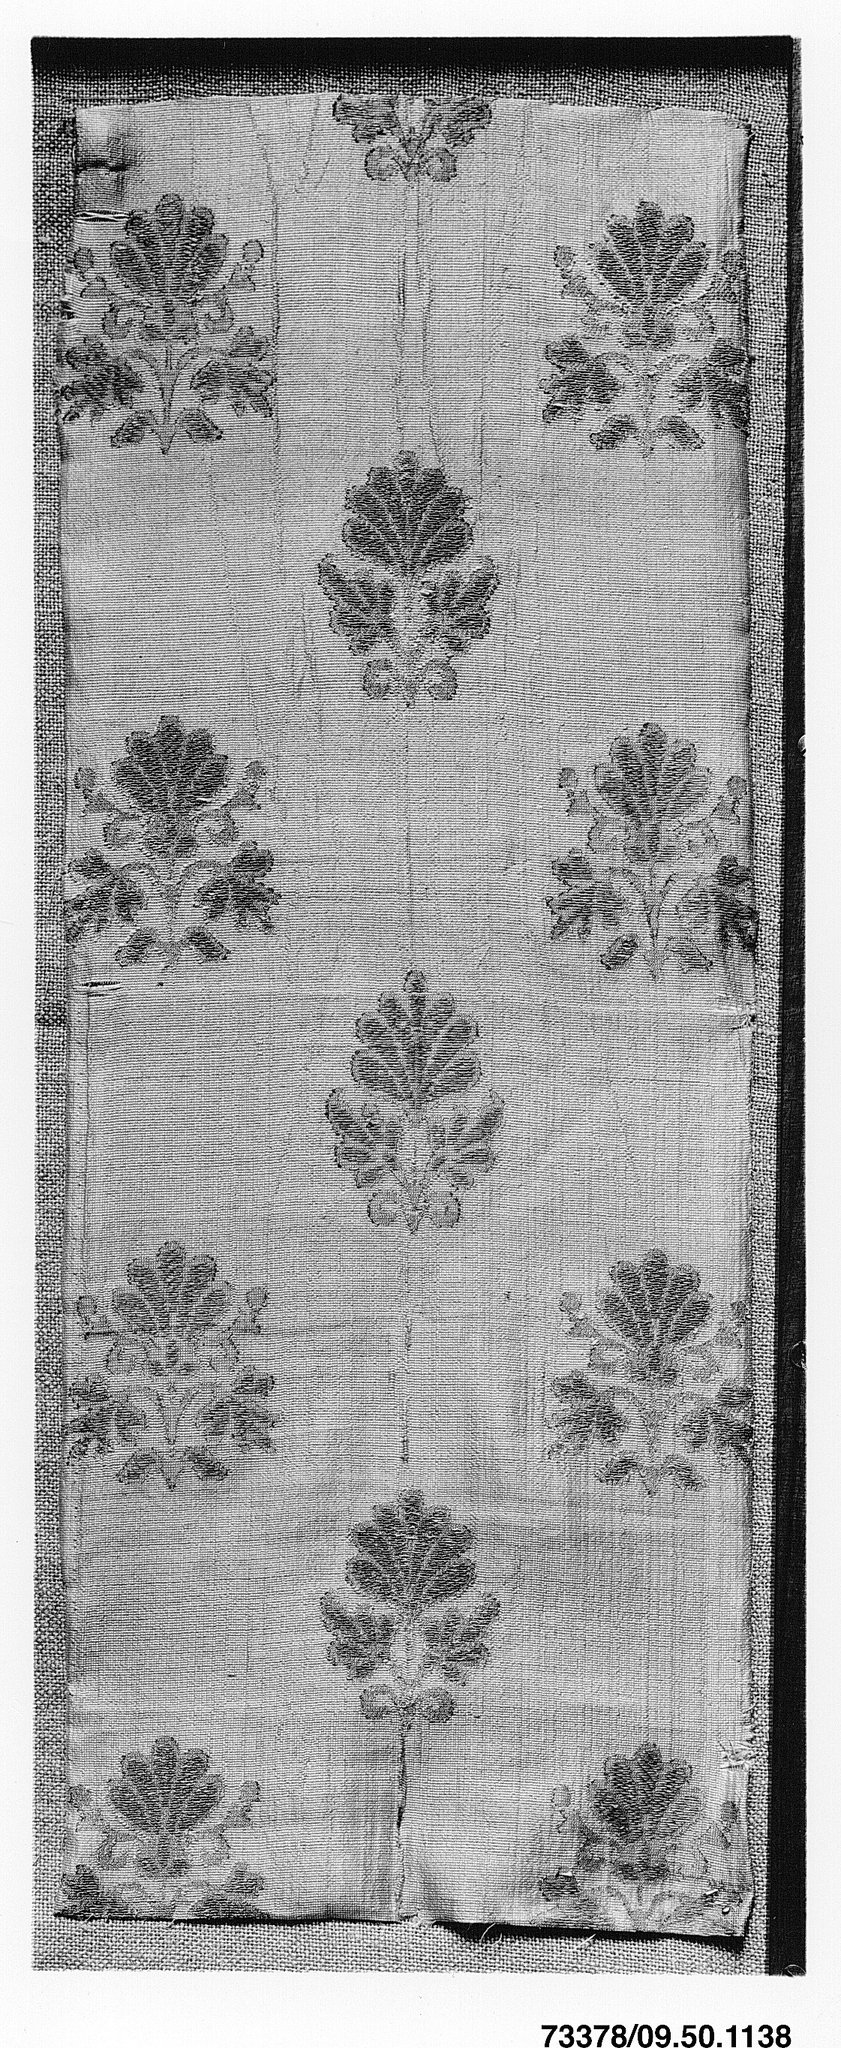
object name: piece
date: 1501-1600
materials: metal thread, silk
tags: flowers,leaves